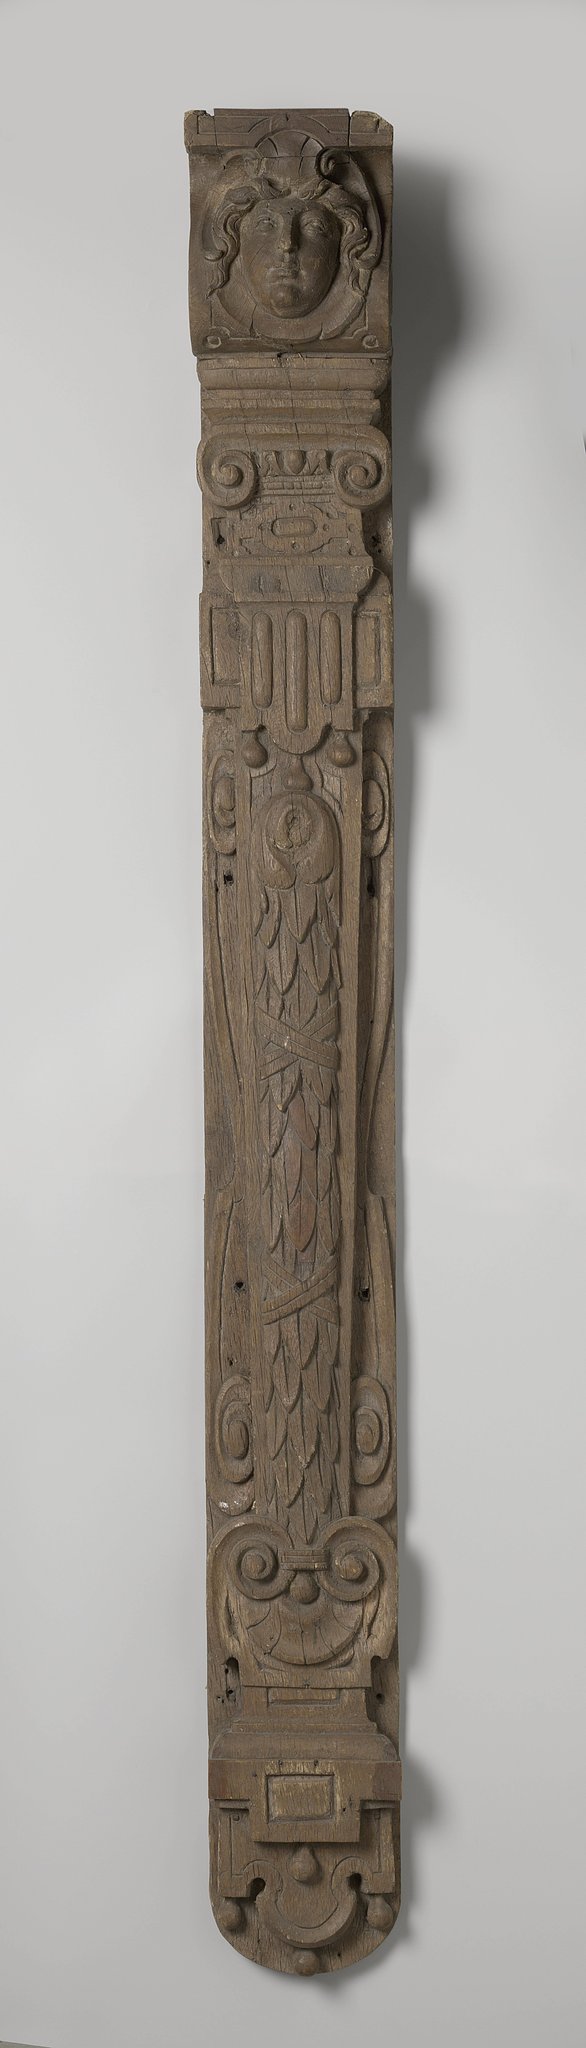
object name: stile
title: Gebeeldhouwde stijl van eikenhout, afkomstig uit het z.g. Huis van Alva, Warmoestraat te Amsterdam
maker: Anonymous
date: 1500-1699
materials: wood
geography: northern netherlands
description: Gebeeldhouwde eikenhouten stijl zonder afwerking, afkomstig uit het z.g. Huis van Alva, Warmoestraat te Amsterdam. In totaal gaat het om twee consoles, drie brede en drie smalle stijlen (BK-KOG-755-B t/m H). Zie tevens BK-KOG-754-1 t/m 7, dit zijn 6 beschilderde stijlen die uit hetzelfde huis afkomstig zijn.